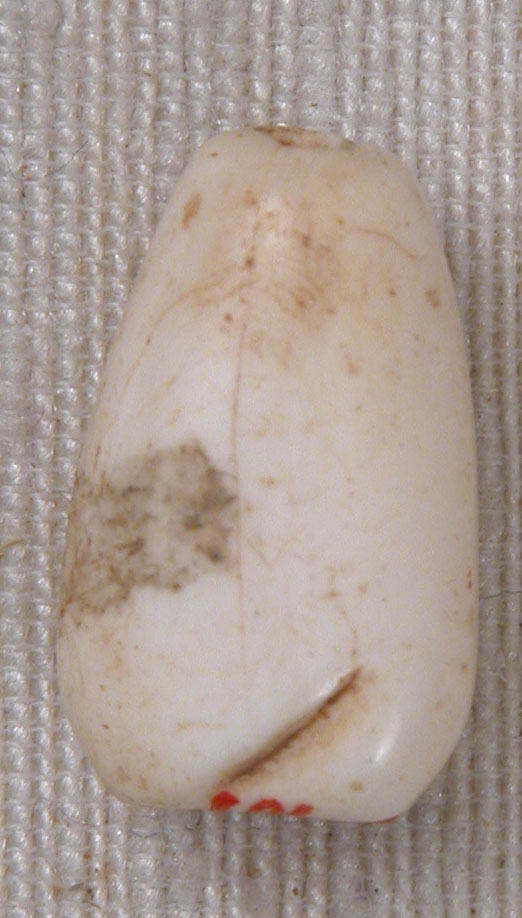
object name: bead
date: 701-1300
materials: shell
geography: iran